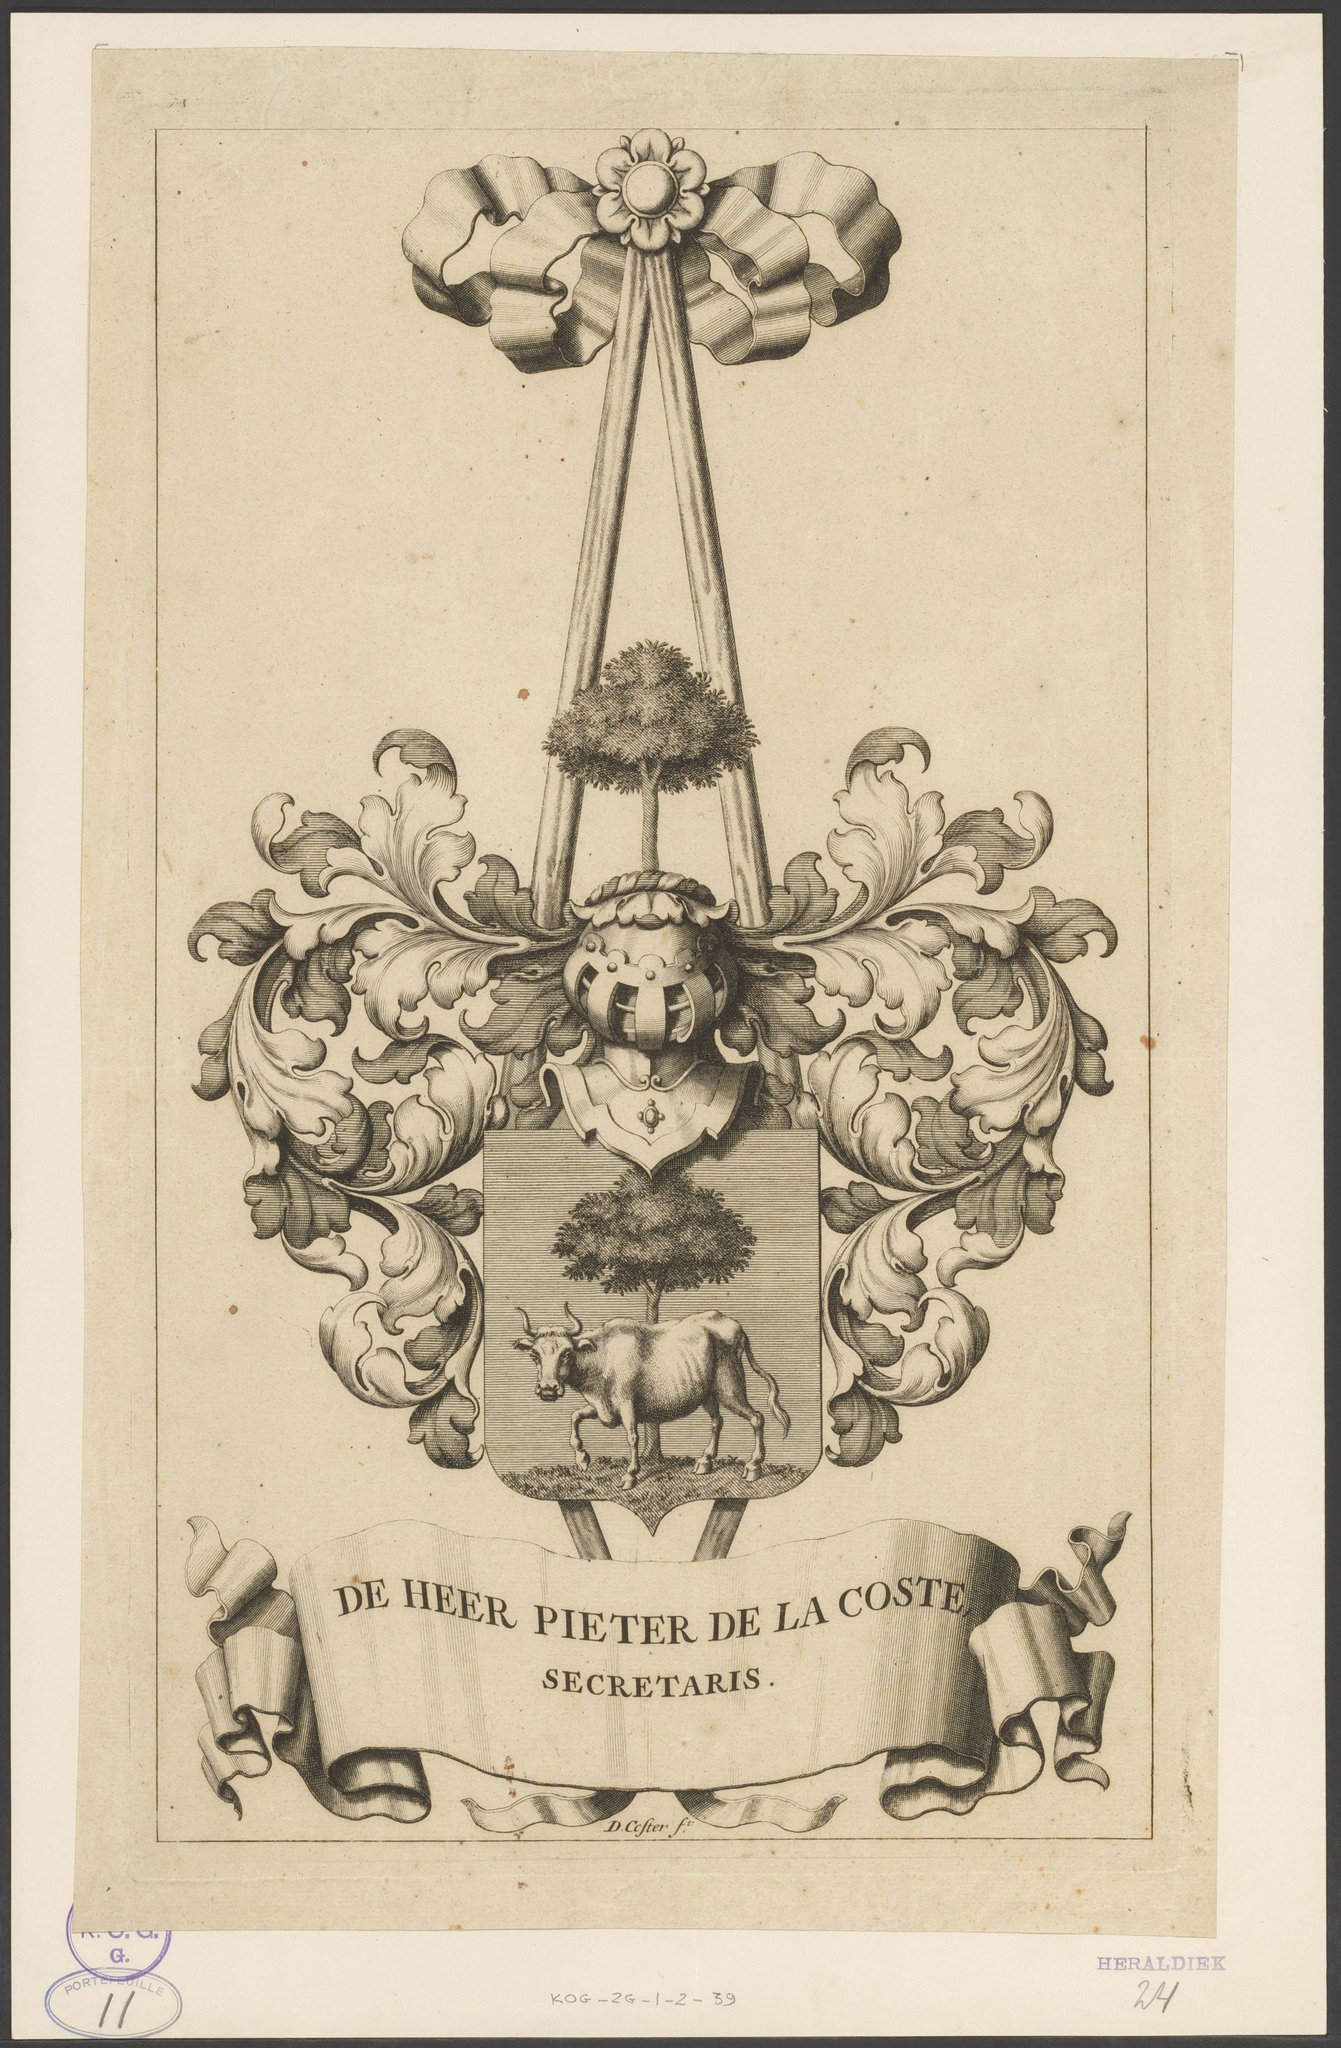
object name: print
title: Familiewapen van Pieter de la Coste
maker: david coster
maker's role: print maker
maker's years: 1676-1752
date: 1683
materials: paper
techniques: engraving, etching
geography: amsterdam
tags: armorial bearing, heraldry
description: Deze prent maakt deel uit van de wapenrand van de kaart van het Hoogheemraadschap van de Krimpenerwaard, van deze kaart zijn voor zover na te gaan acht verschillende drukken bekend, uit respectievelijk 1683, 1696, 1706, 1735, 1741, 1755, 1792 en 1818. De wapenrand is voor elke druk geheel of deels opnieuw werd gegraveerd. Een identiek exemplaar van deze prent (RP-P-AO-14-5-31) is gecatalogiseerd als deel uitmakend van de editie van 1741.